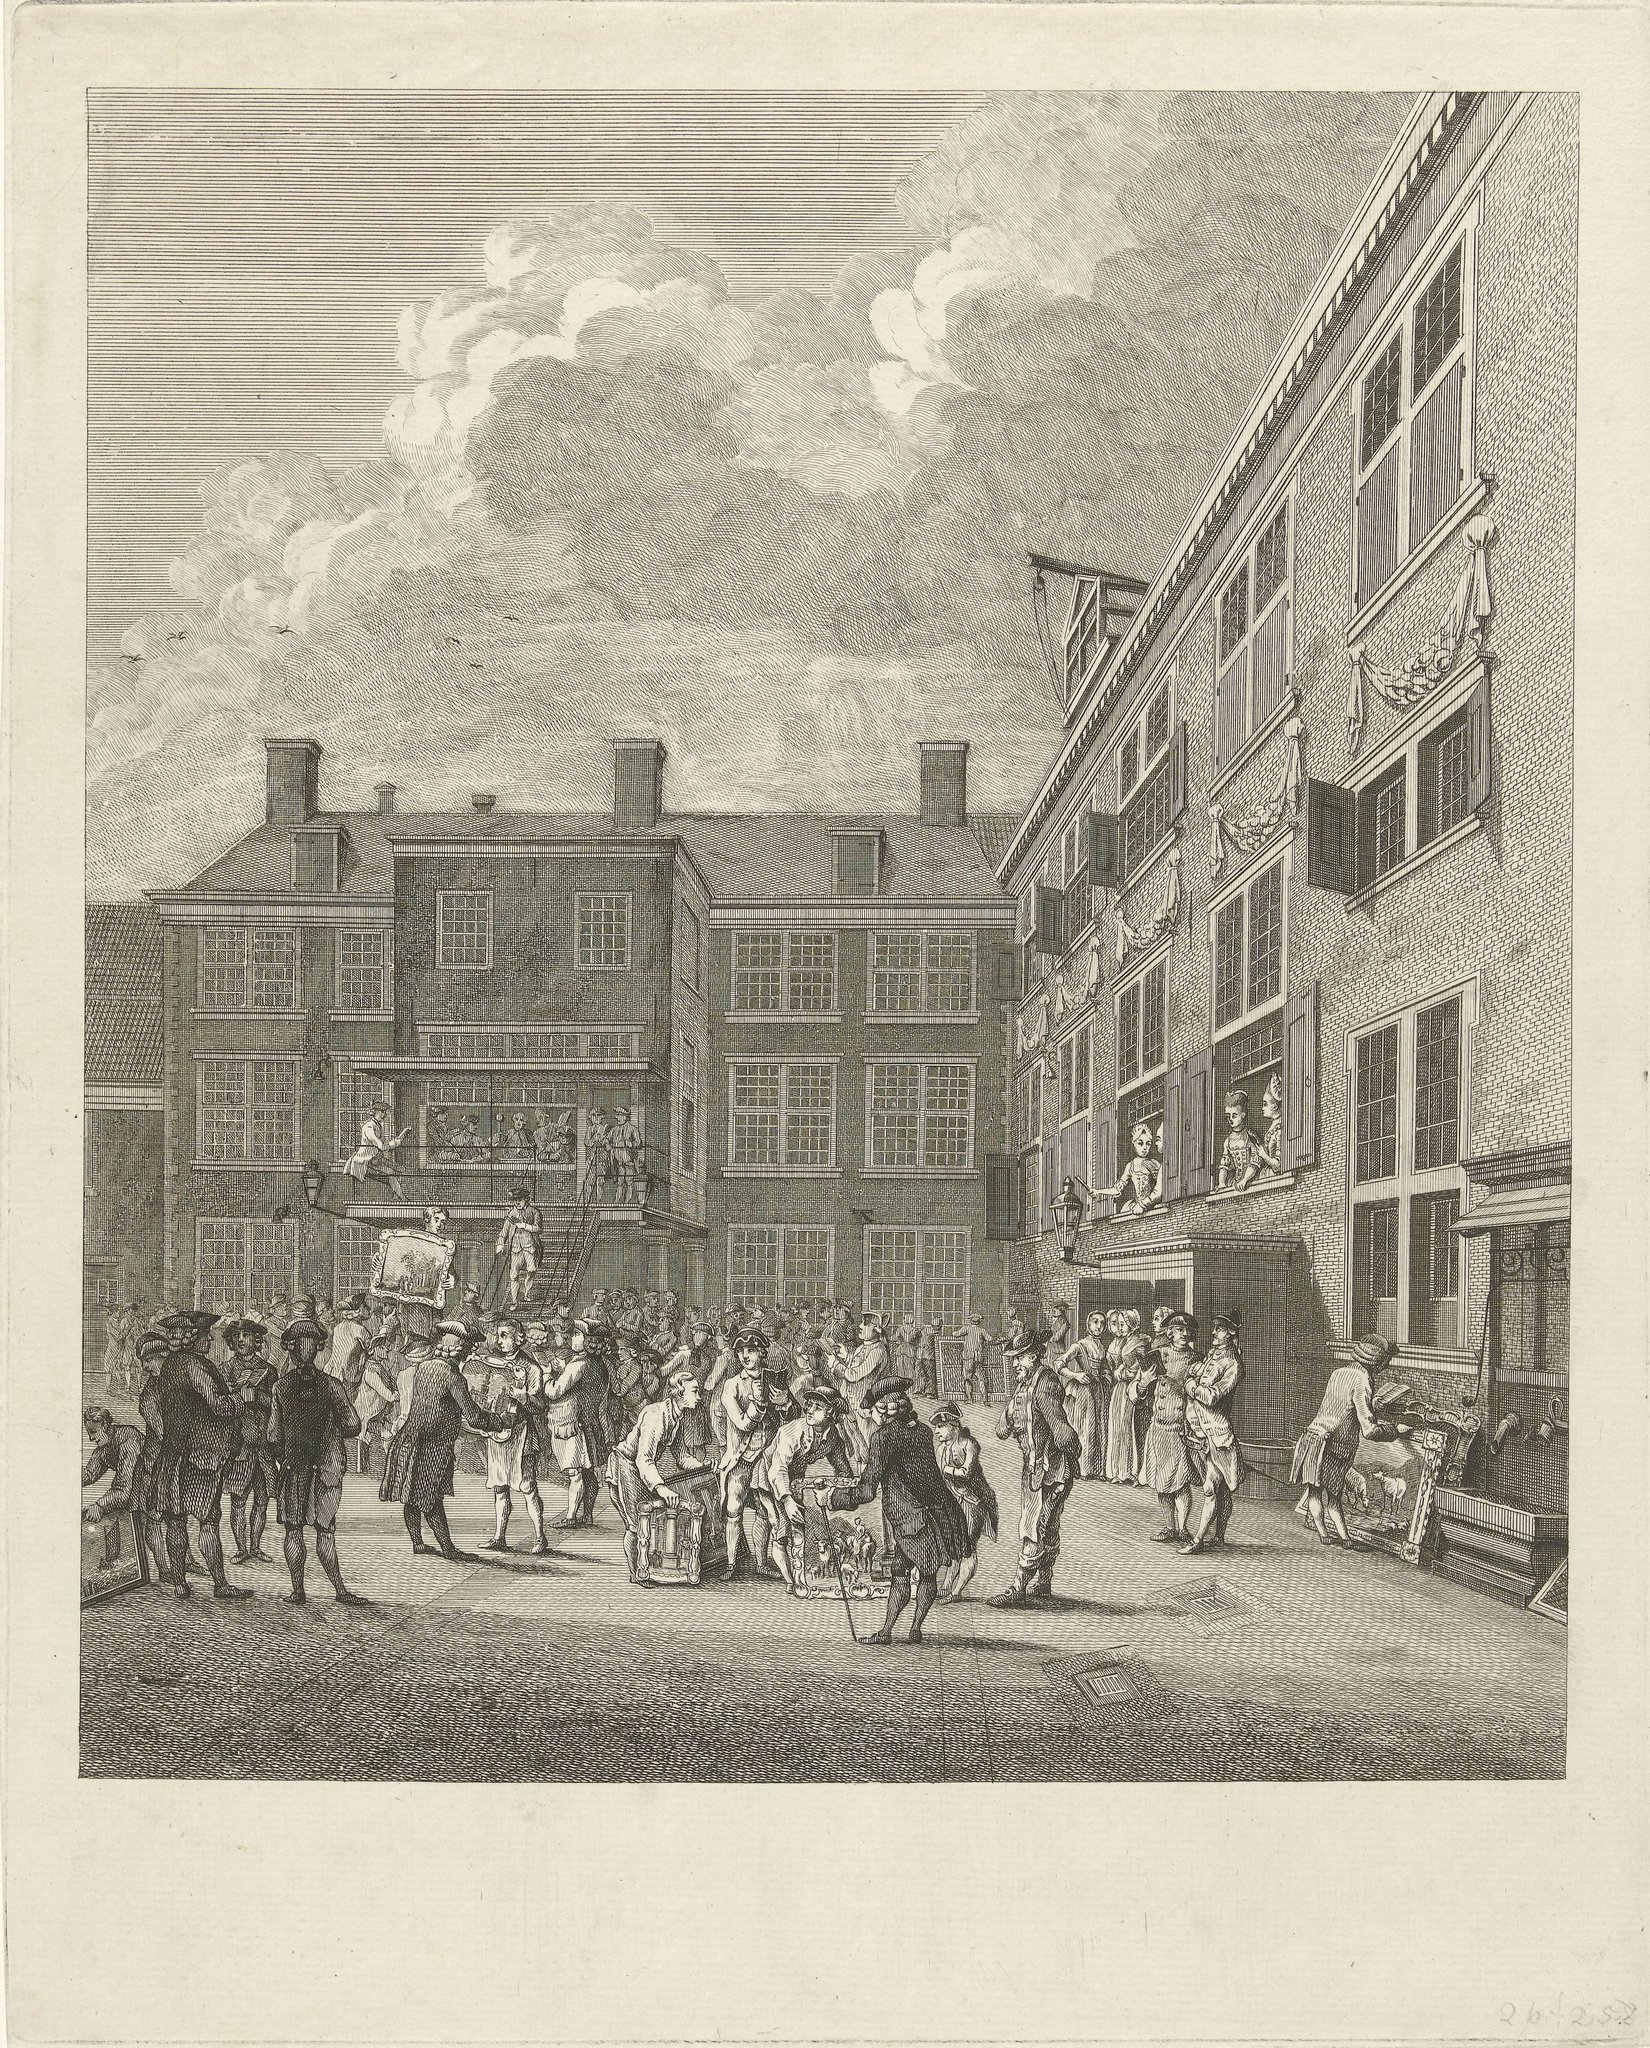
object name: print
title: Schilderijenverkoop op de binnenplaats van het Oudezijds Herenlogement te Amsterdam, 1773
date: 1773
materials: paper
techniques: etching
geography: amsterdam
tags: hotel, hostelry, inn, art sale, auction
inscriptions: collector's mark: Lugt 2228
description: Latere staten van deze prent zijn ook gebruikt in de zogenaamde Atlas van Fouquet.* Pierre Fouquet gaf vanaf 1760 stadsgezichten van Amsterdam - naar tekeningen van verschillende kunstenaars, gemaakt door verschillende prentmakers - uit. Deze prenten werden aanvankelijk los of in series verkocht. Zoals toen gebruikelijk kon de koper de prenten zelf laten inbinden. Hiertoe gaf Fouquet tussen 1778 en 1783 een titelblad, plattegrond en inhoudsopgave van de tot dusver 100 uitgegeven prenten uit (1). Gezien de inhoud afhankelijk was van wat de koper had verzameld verschilt de inhoud van de verschillende bewaarde Fouquetatlassen onder deze titel sterk. Ook zijn er exemplaren bekend waar tevens andere prenten aan zijn toegevoegd. Omdat er behoefte bleek aan uitleg bij de platen werd in 1783 een nieuwe versie van de atlas uitgegeven, aangevuld met tekst en twee prenten. De aangegeven volgorde veranderde maar de platen van de al eerder uitgegeven prenten bleven ongewijzigd. Deze uitgave werd in opdracht van Fouquet gedrukt bij Daniël Jean Changuion en Petrus den Hengst (2). Een tiental platen werd bijgewerkt en verscheen, met nieuw impressum, in het vervolg van Wagenaars geschiedenis van Amsterdam, uitgeven door Petrus Conradi en Folkert van der Plaats (3). Een aantal jaar na het overlijden van Fouquet kwam Evert Maaskamp met een nieuwe uitgave van de atlas, met verbeterde tekst en toevoeging van twee prenten. Op alle platen verwijderde hij het oude en liet hij zijn eigen impressum zetten (4). * Onder de Atlas van Fouquet of Fouquetatlas verstaan we de hieronder vermelde publicaties (1), (2) en (4). (1). Afbeeldingen van de wyd-vermaarde koopstad Amsterdam benevens des zelvs voornaamste gebouwen en gezigten alle naar het leeven getekend / Receuil des edifices les plus considerables et des plus belles vues, de la fameuse ville d'Amsterdam, dessinées d'après nature. Amsterdam: Pierre Fouquet, 1778-1783. (2). Nieuwe atlas, van de voornaamste gebouwen en gezigten der stad Amsterdam, met derzelver beknopte beschryvingen. 2 delen. Amsterdam: Daniël Jean Changuion en Petrus den Hengst [in opdracht van Pierre Fouquet], 1783. (3). Stijl, Simon. Amsterdam, in zyne geschiedenissen, voorregten, koophandel, gebouwen, kerkenstaat, schoolen, schutterye, gilden en regeeringe, beschreeven. Om te dienen ten vervolge op het werk van Jan Wagenaar (…). 10 delen. Amsterdam en Harlingen: Petrus Conradi en Folkert van der Plaats, 1788-1801. (4). Nieuwe atlas, van de voornaamste gebouwen en gezigten der stad Amsterdam. Met derzelver beknopte beschryvingen. Amsterdam: Evert Maaskamp, 1805. * Het aantal vermelde staten is gebaseerd op het aantal gevonden staten. Mogelijk zijn er meer staten van deze prent.